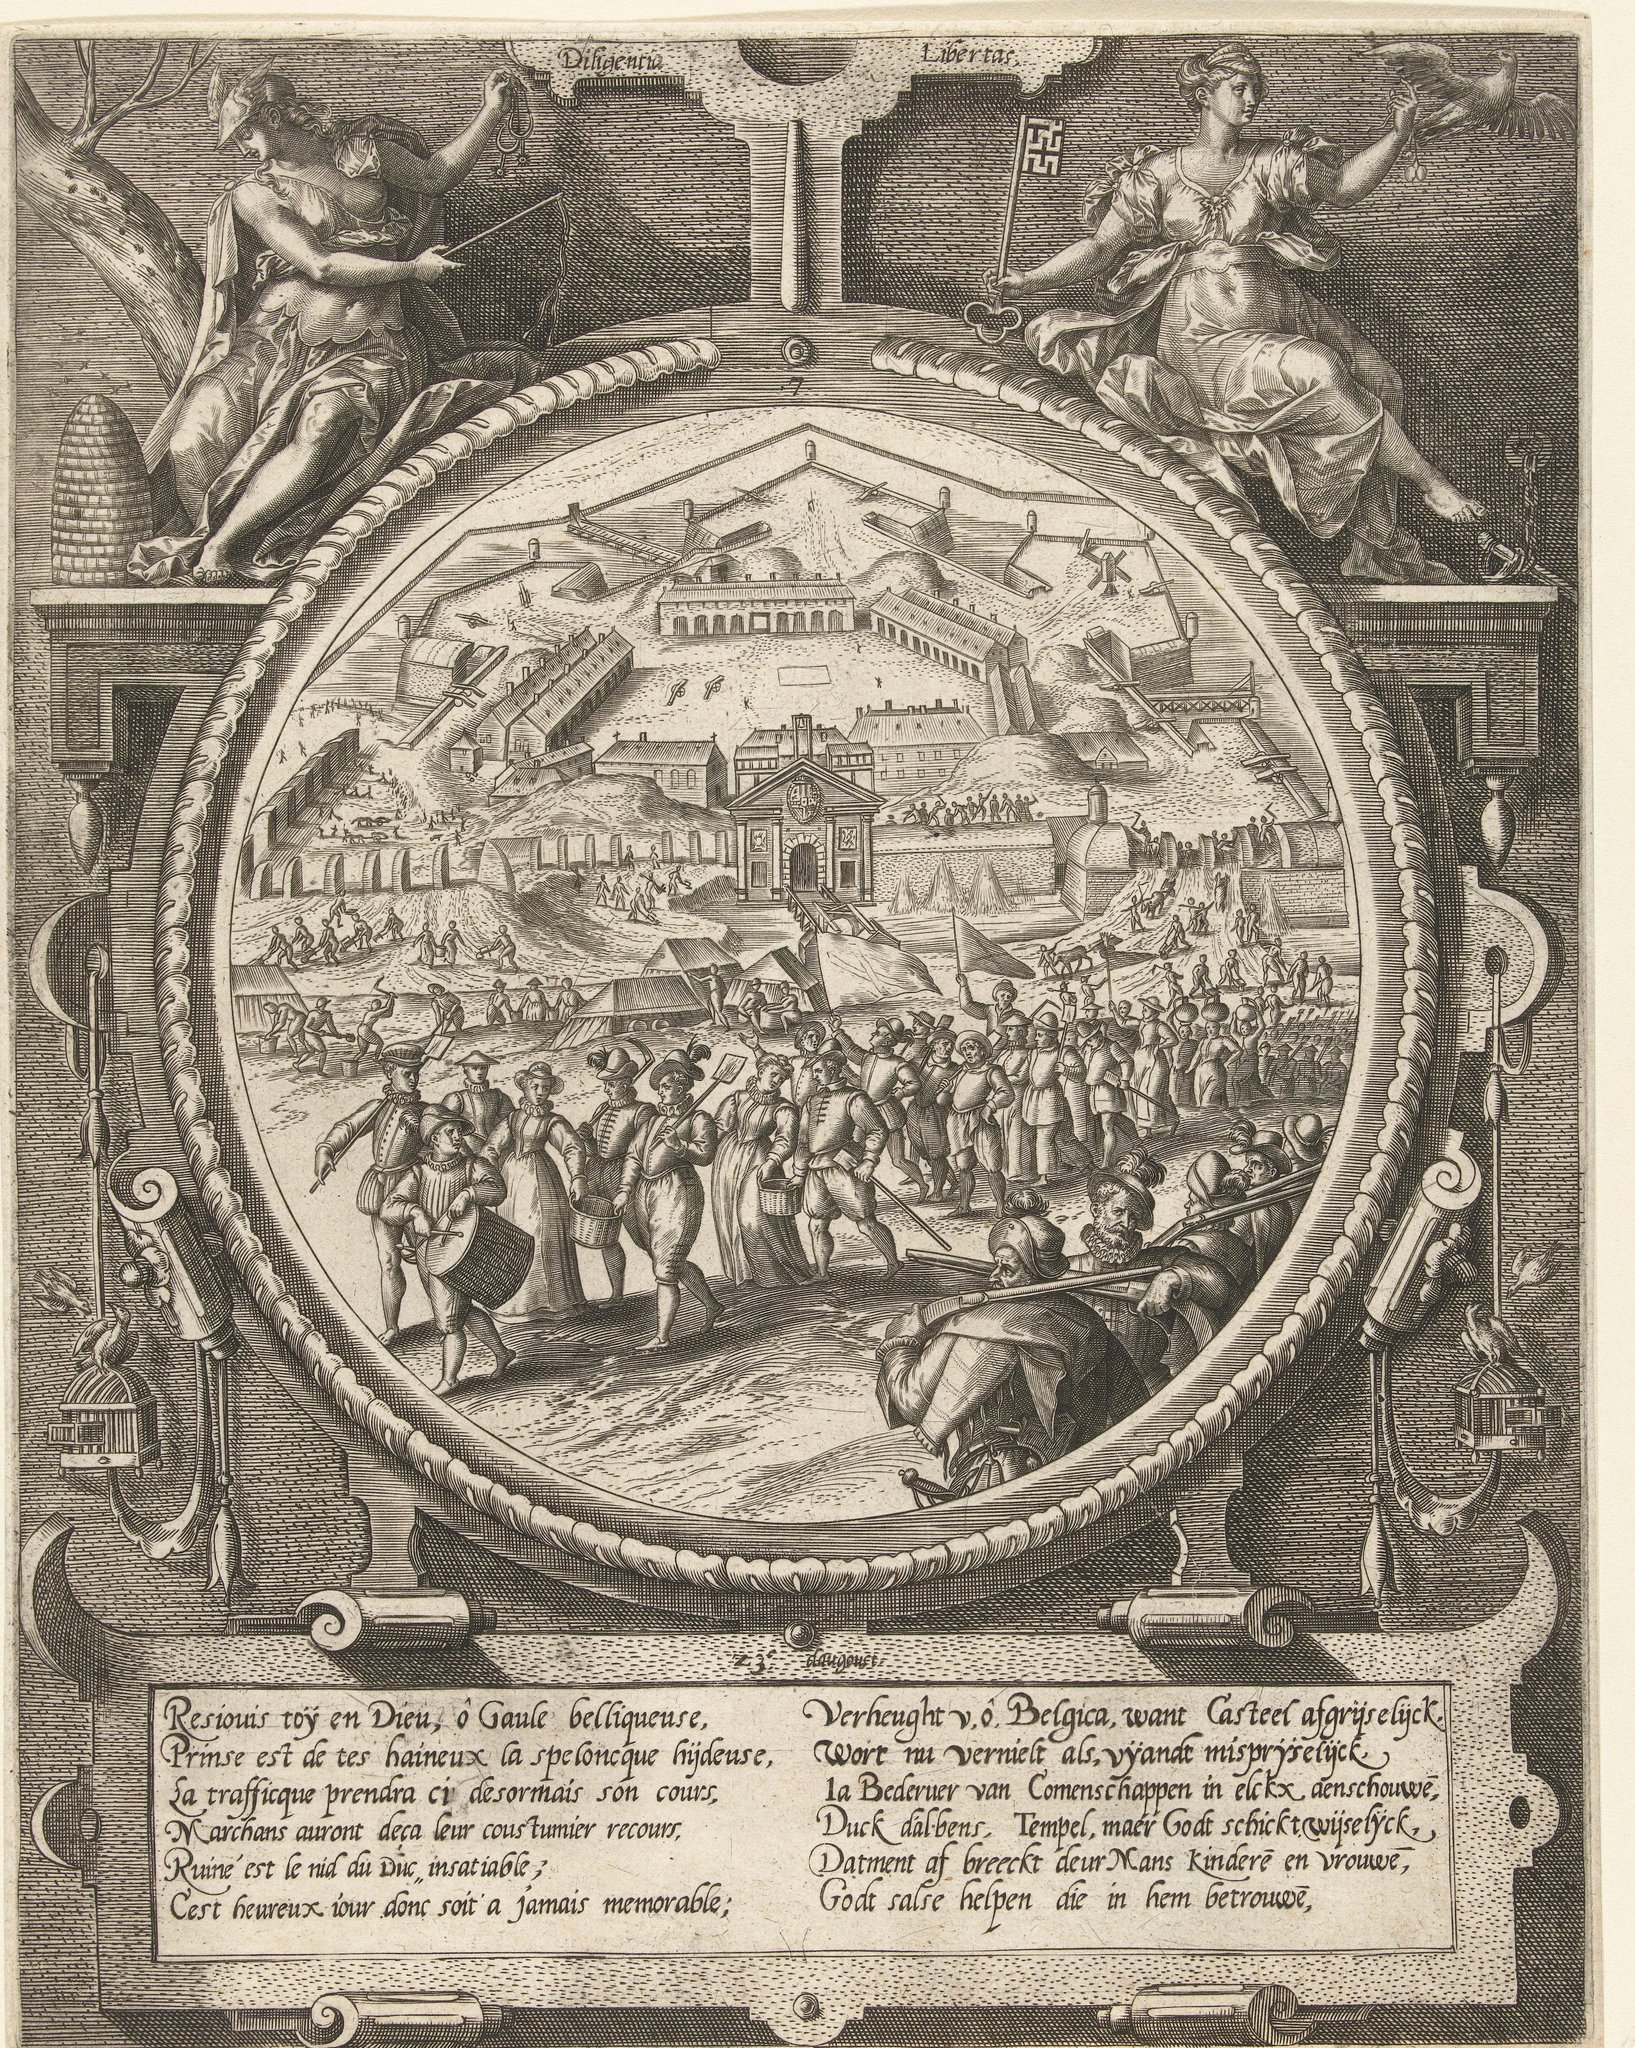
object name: propagandaprent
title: Medaillons met de verovering van de citadel van Antwerpen in 1577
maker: wierix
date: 1578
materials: paper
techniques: engraving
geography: antwerp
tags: industriousness, assiduity; 'assiduità', 'industria', 'zelo' (ripa), demolition of building, freedom, liberty; 'libertà' (ripa), carefulness, diligence; 'diligenza' (ripa)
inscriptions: collector's mark: Lugt 2760, collector's mark: Lugt 2228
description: Het afgraven van de bolwerken door de Antwerpenaren, 23 augustus 1577. Optocht van inwoners van Antwerpen gewapend met spades en manden op weg naar de citadel. Op de achtergrond het slopen en afgraven van de vesting. Voorstelling in een rond medaillon met ornamentele allegorische omlijsting met bovenaan de zittende vrouwelijke personificaties van Vlijt (Diligentia) en Vrijheid (Libertas). Onderaan een cartouche met 2 verzen van elk 6 regels in het Frans en Nederlands.